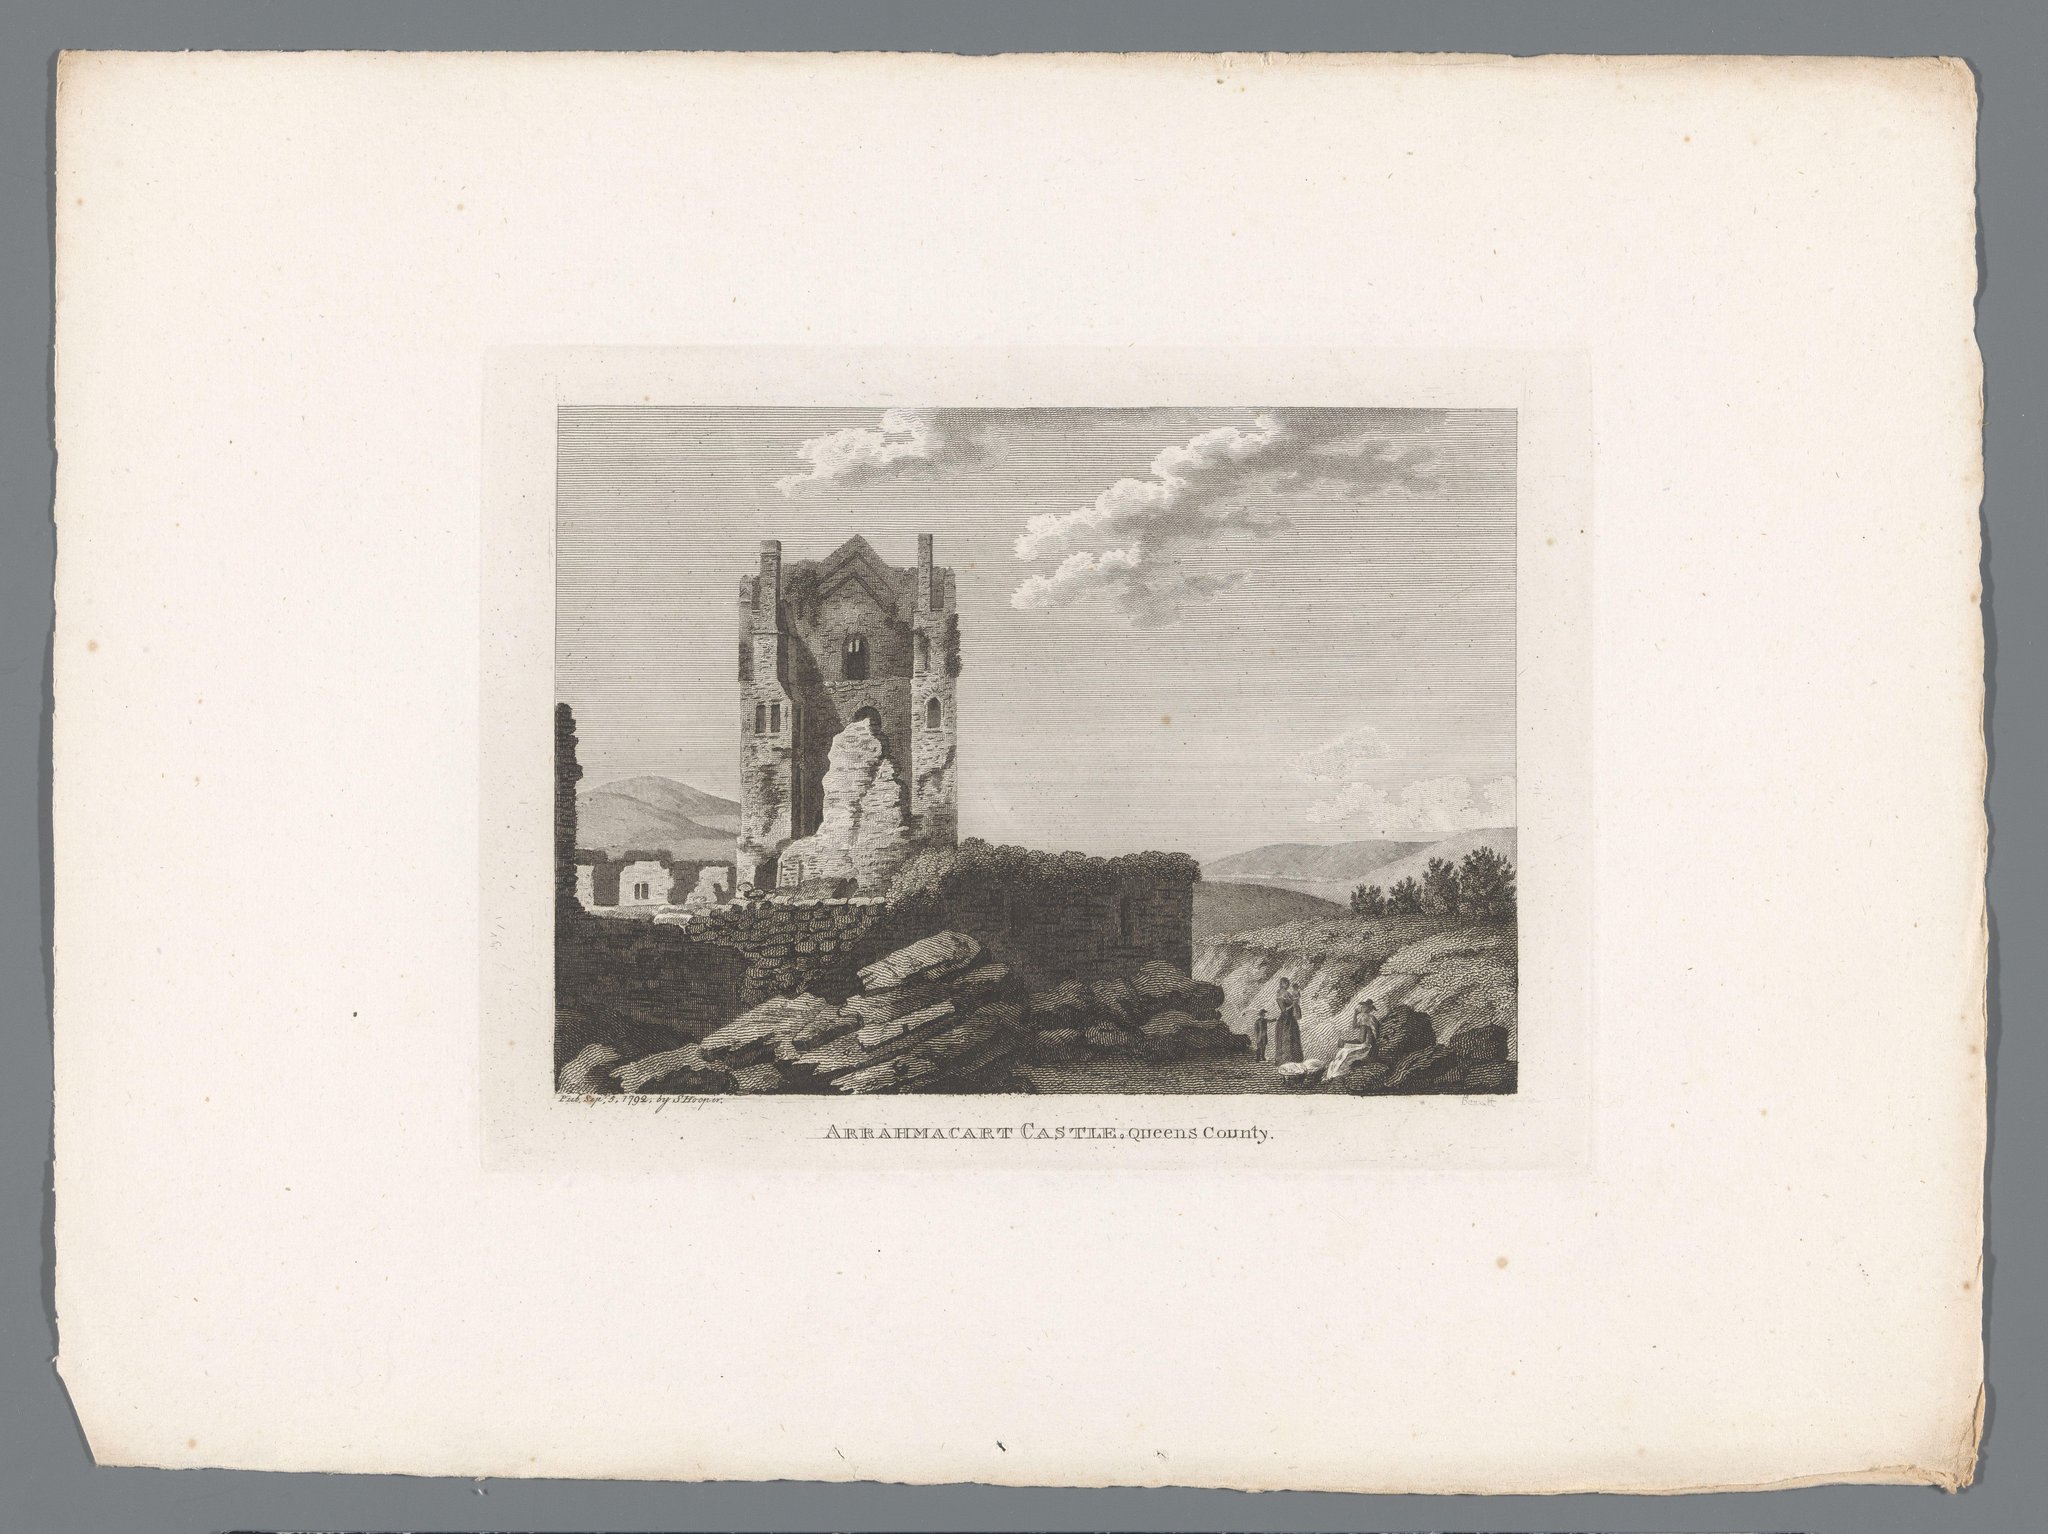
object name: book illustration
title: Gezicht op de ruïnes van Arrahmacart Castle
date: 1792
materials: paper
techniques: etching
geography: london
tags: landscape with ruins, landscape with tower or castle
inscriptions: date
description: Prent verschenen in: Grose, Francis. The antiquities of Ireland. Londen: S. Hooper, 1795, dl. 2.